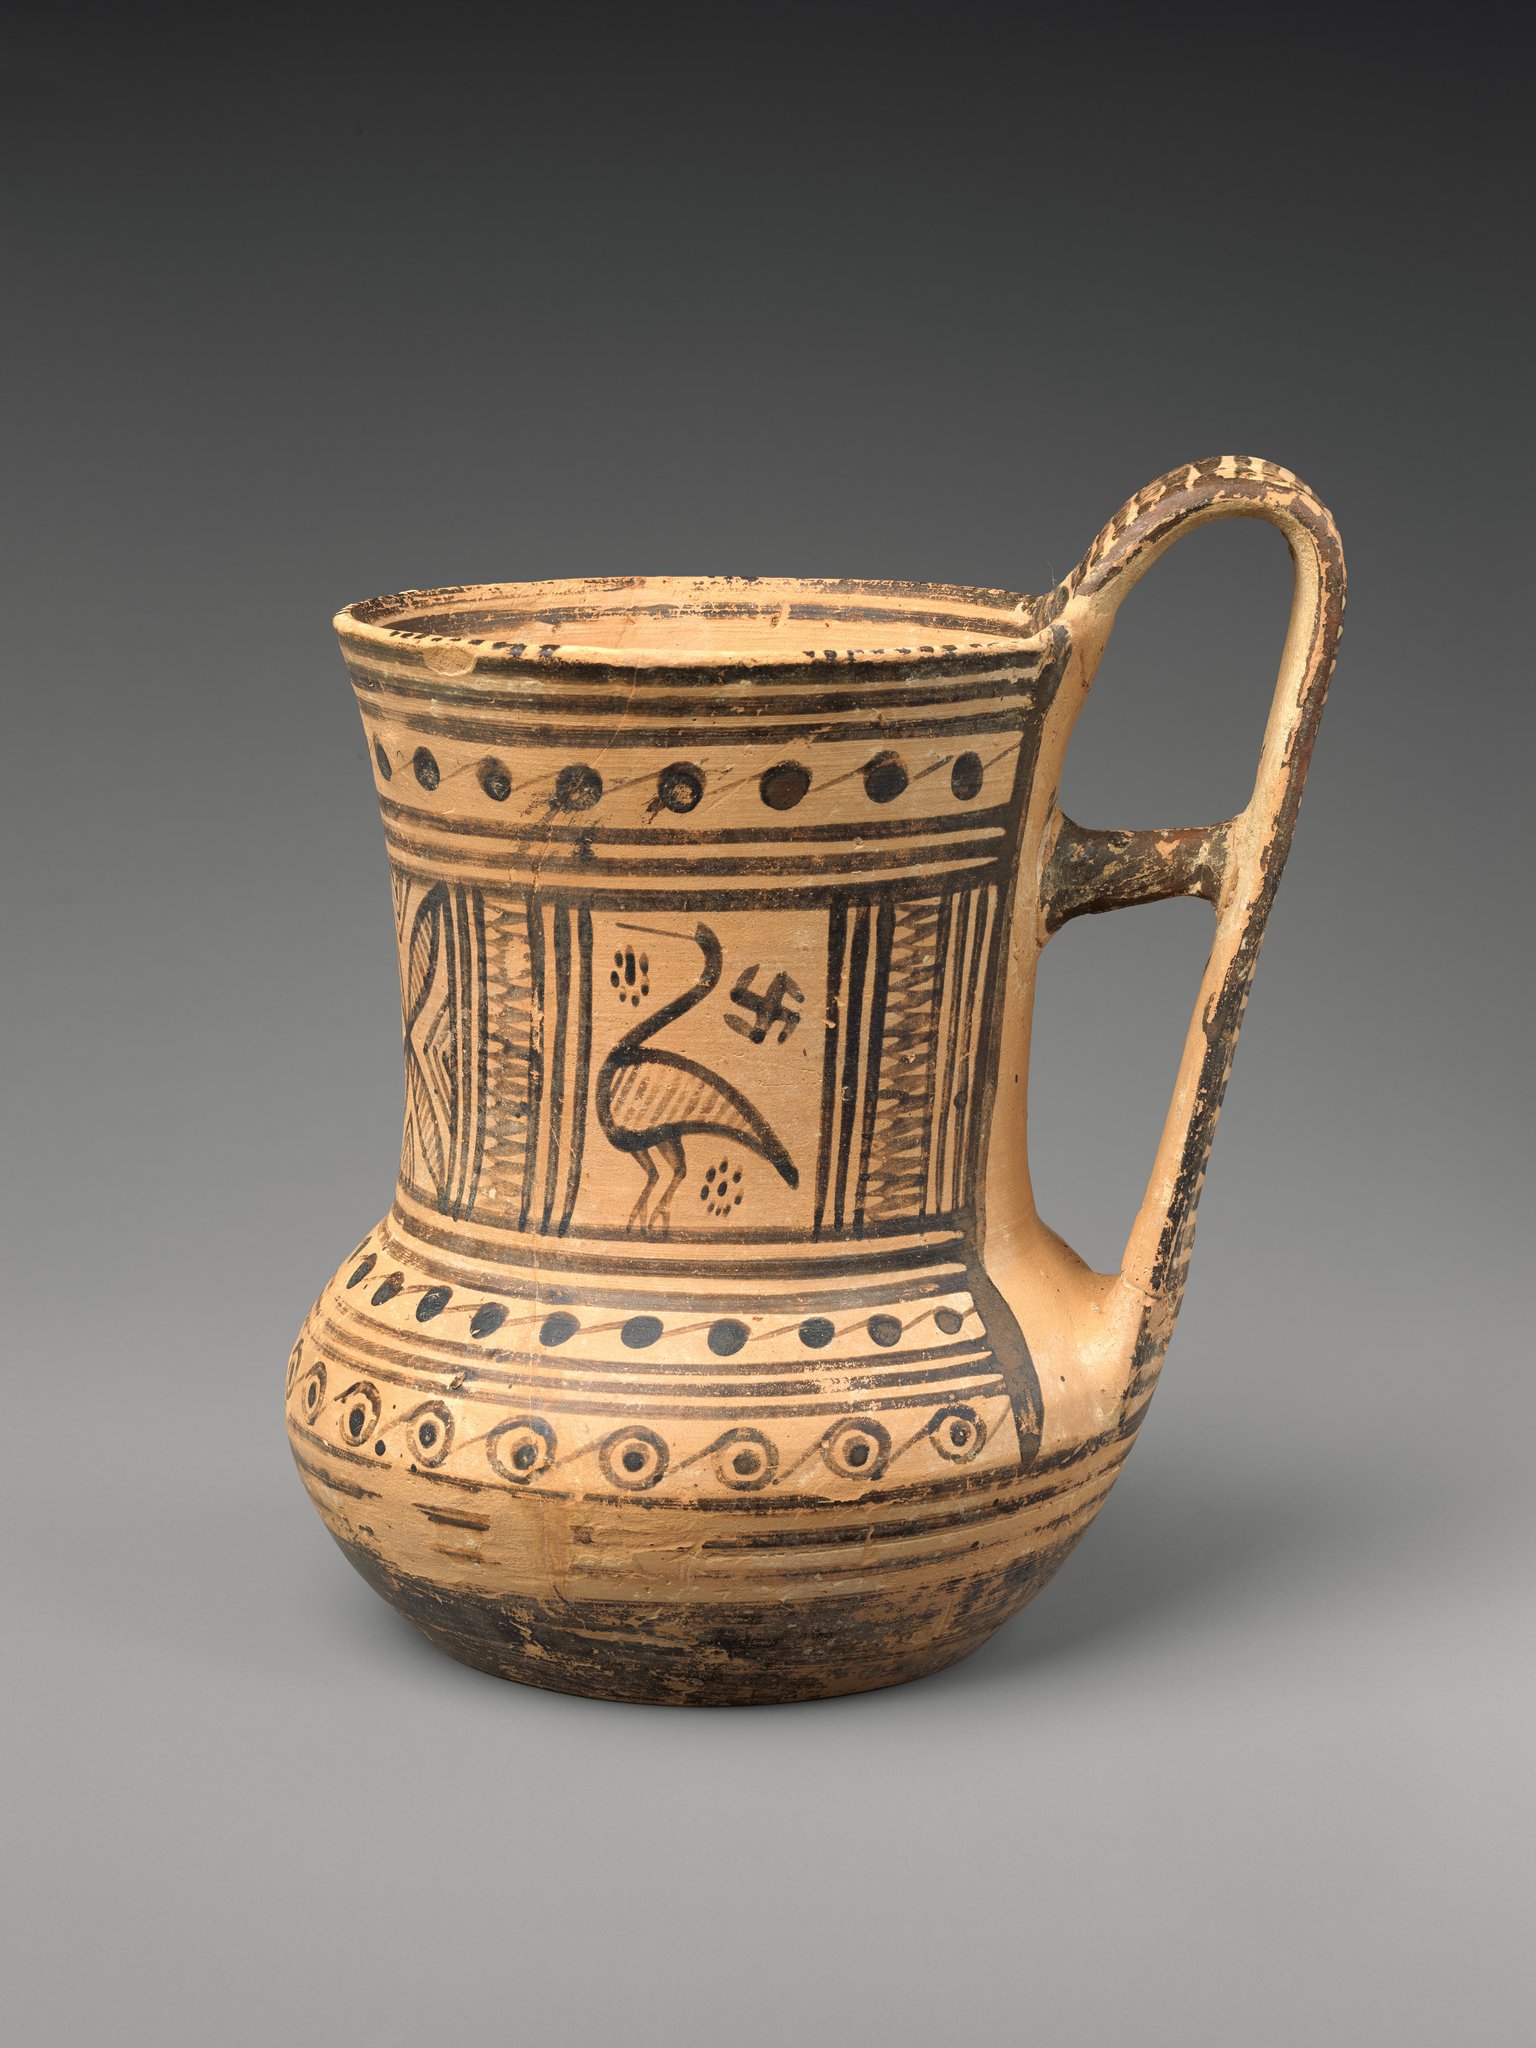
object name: jug, tankard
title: Terracotta tankard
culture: greek, attic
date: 750-725 BCE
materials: terracotta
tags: birds